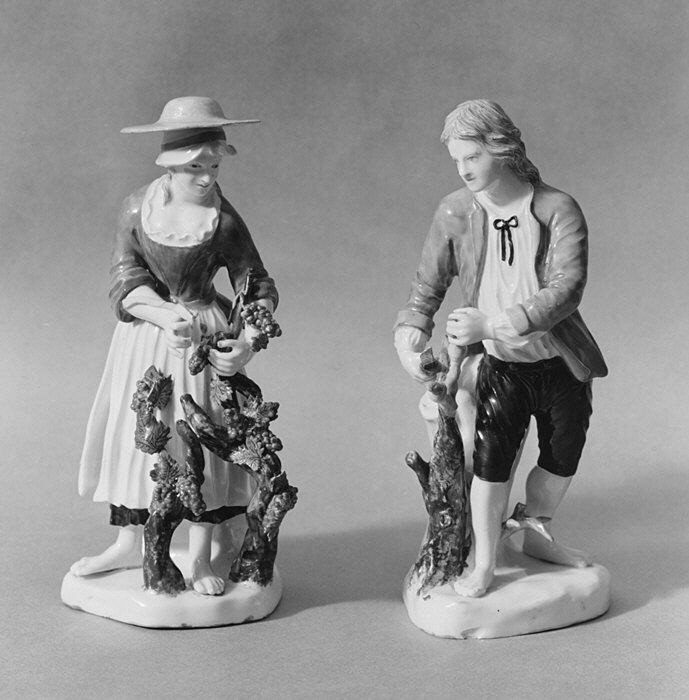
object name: figure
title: Gardener (one of a pair)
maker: höchst manufactory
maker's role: manufactory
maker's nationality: german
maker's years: 1746-1796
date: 1750-1752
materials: hard paste porcelain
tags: men,women,gardeners